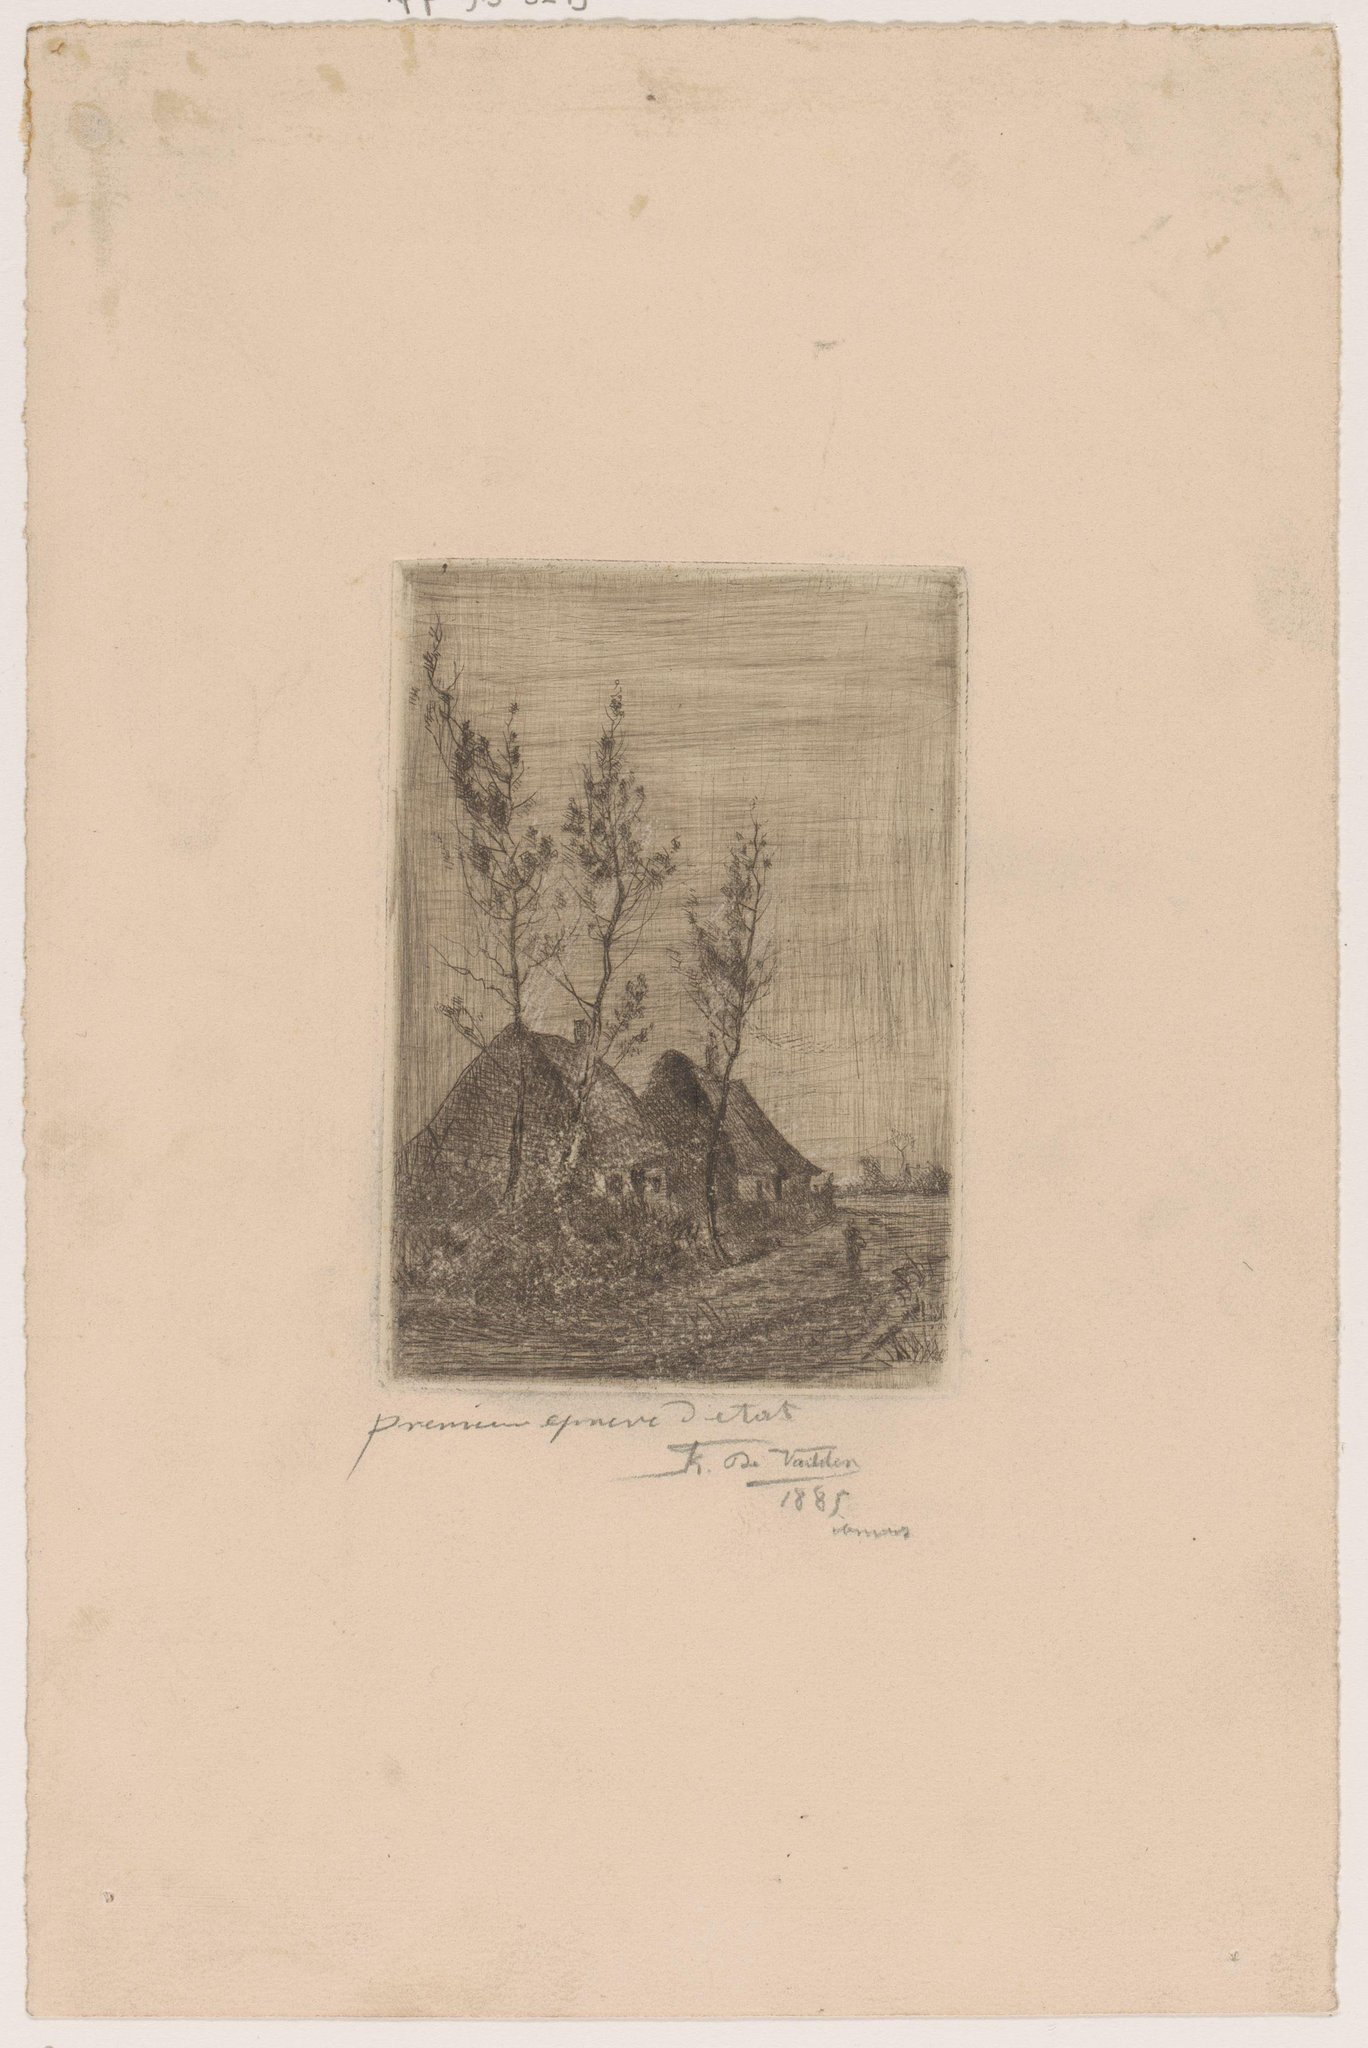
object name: print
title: Twee huizen aan een weg met drie berken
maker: frans de vadder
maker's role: print maker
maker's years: 1862-1936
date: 1885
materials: paper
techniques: etching, intaglio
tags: road, path, trees: birch, farm or solitary house in landscape (+ city(-scape) with figures, staffage)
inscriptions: collector's mark: Lugt 2228, inscription: ‘Premier epreuve d etat; 1885; Anvers’